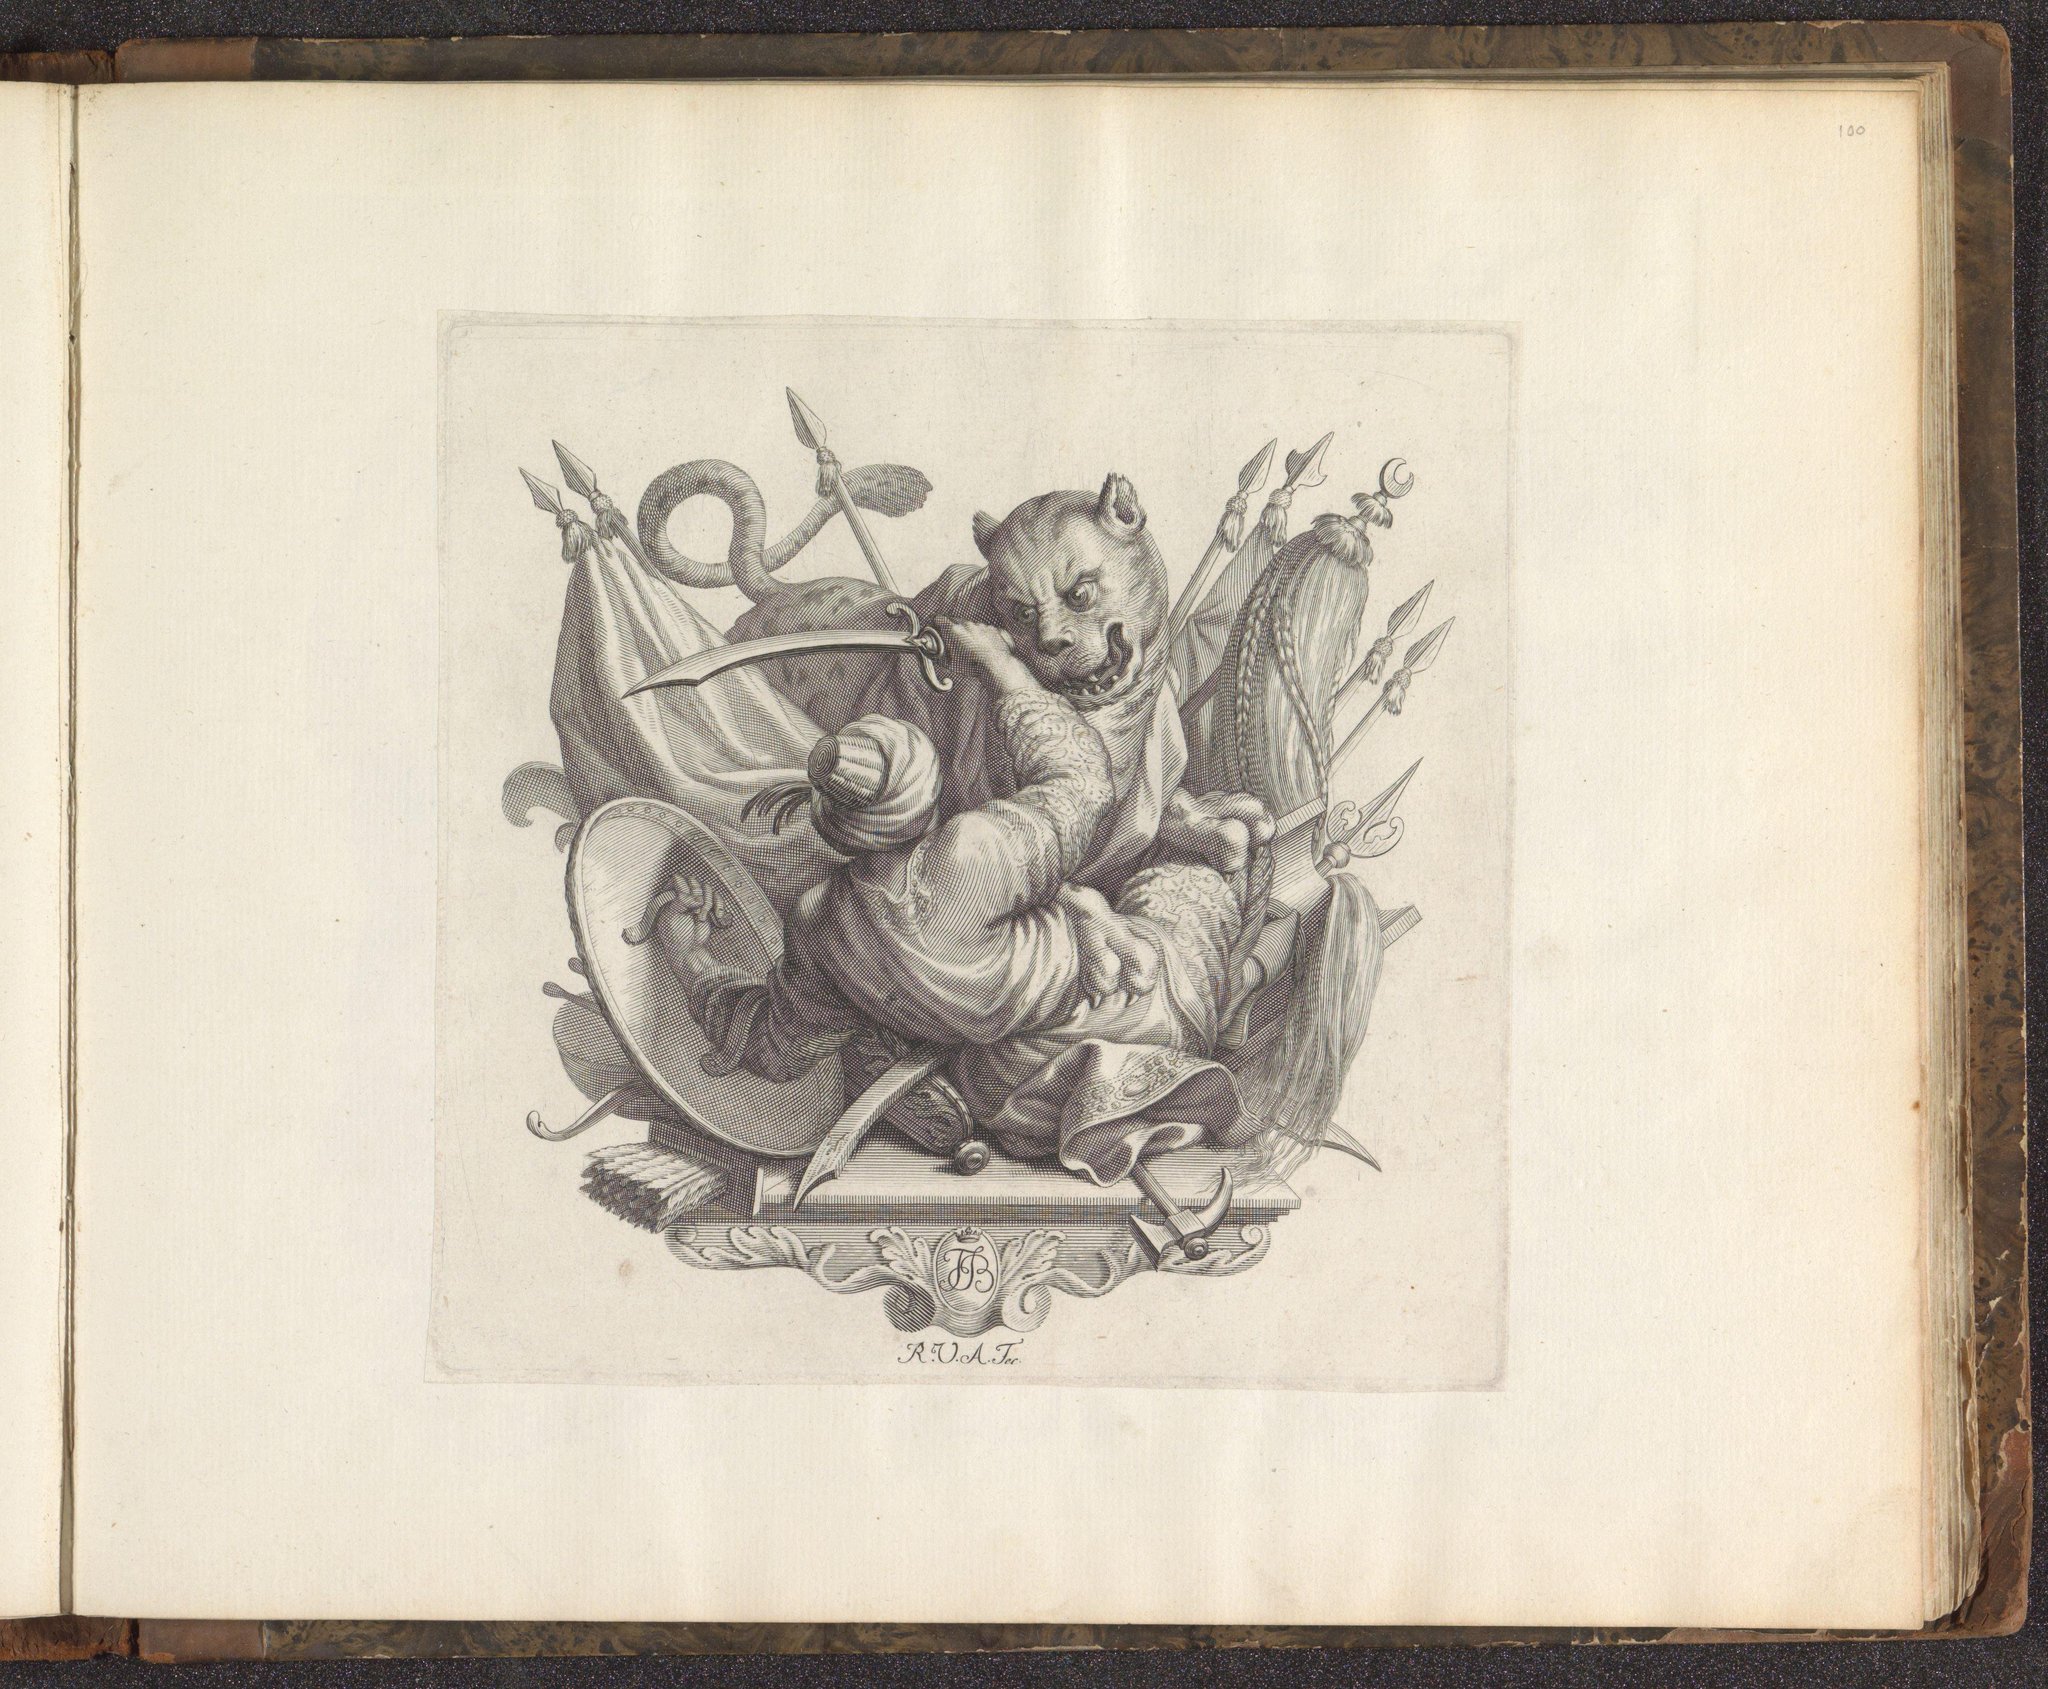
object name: print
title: Numismata virorum illustrium ex Barbadica gente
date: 1673-1743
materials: paper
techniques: engraving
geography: rome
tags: head-gear: turban, man struggling with animals, beasts of prey, predatory animals: lion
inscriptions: collector's mark: Lugt 2228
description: Een console met een man met tulband. Hij wordt overmeesterd door een leeuwin. Links en rechts banieren, pijlen en speren. De prent maakt deel uit van een album.